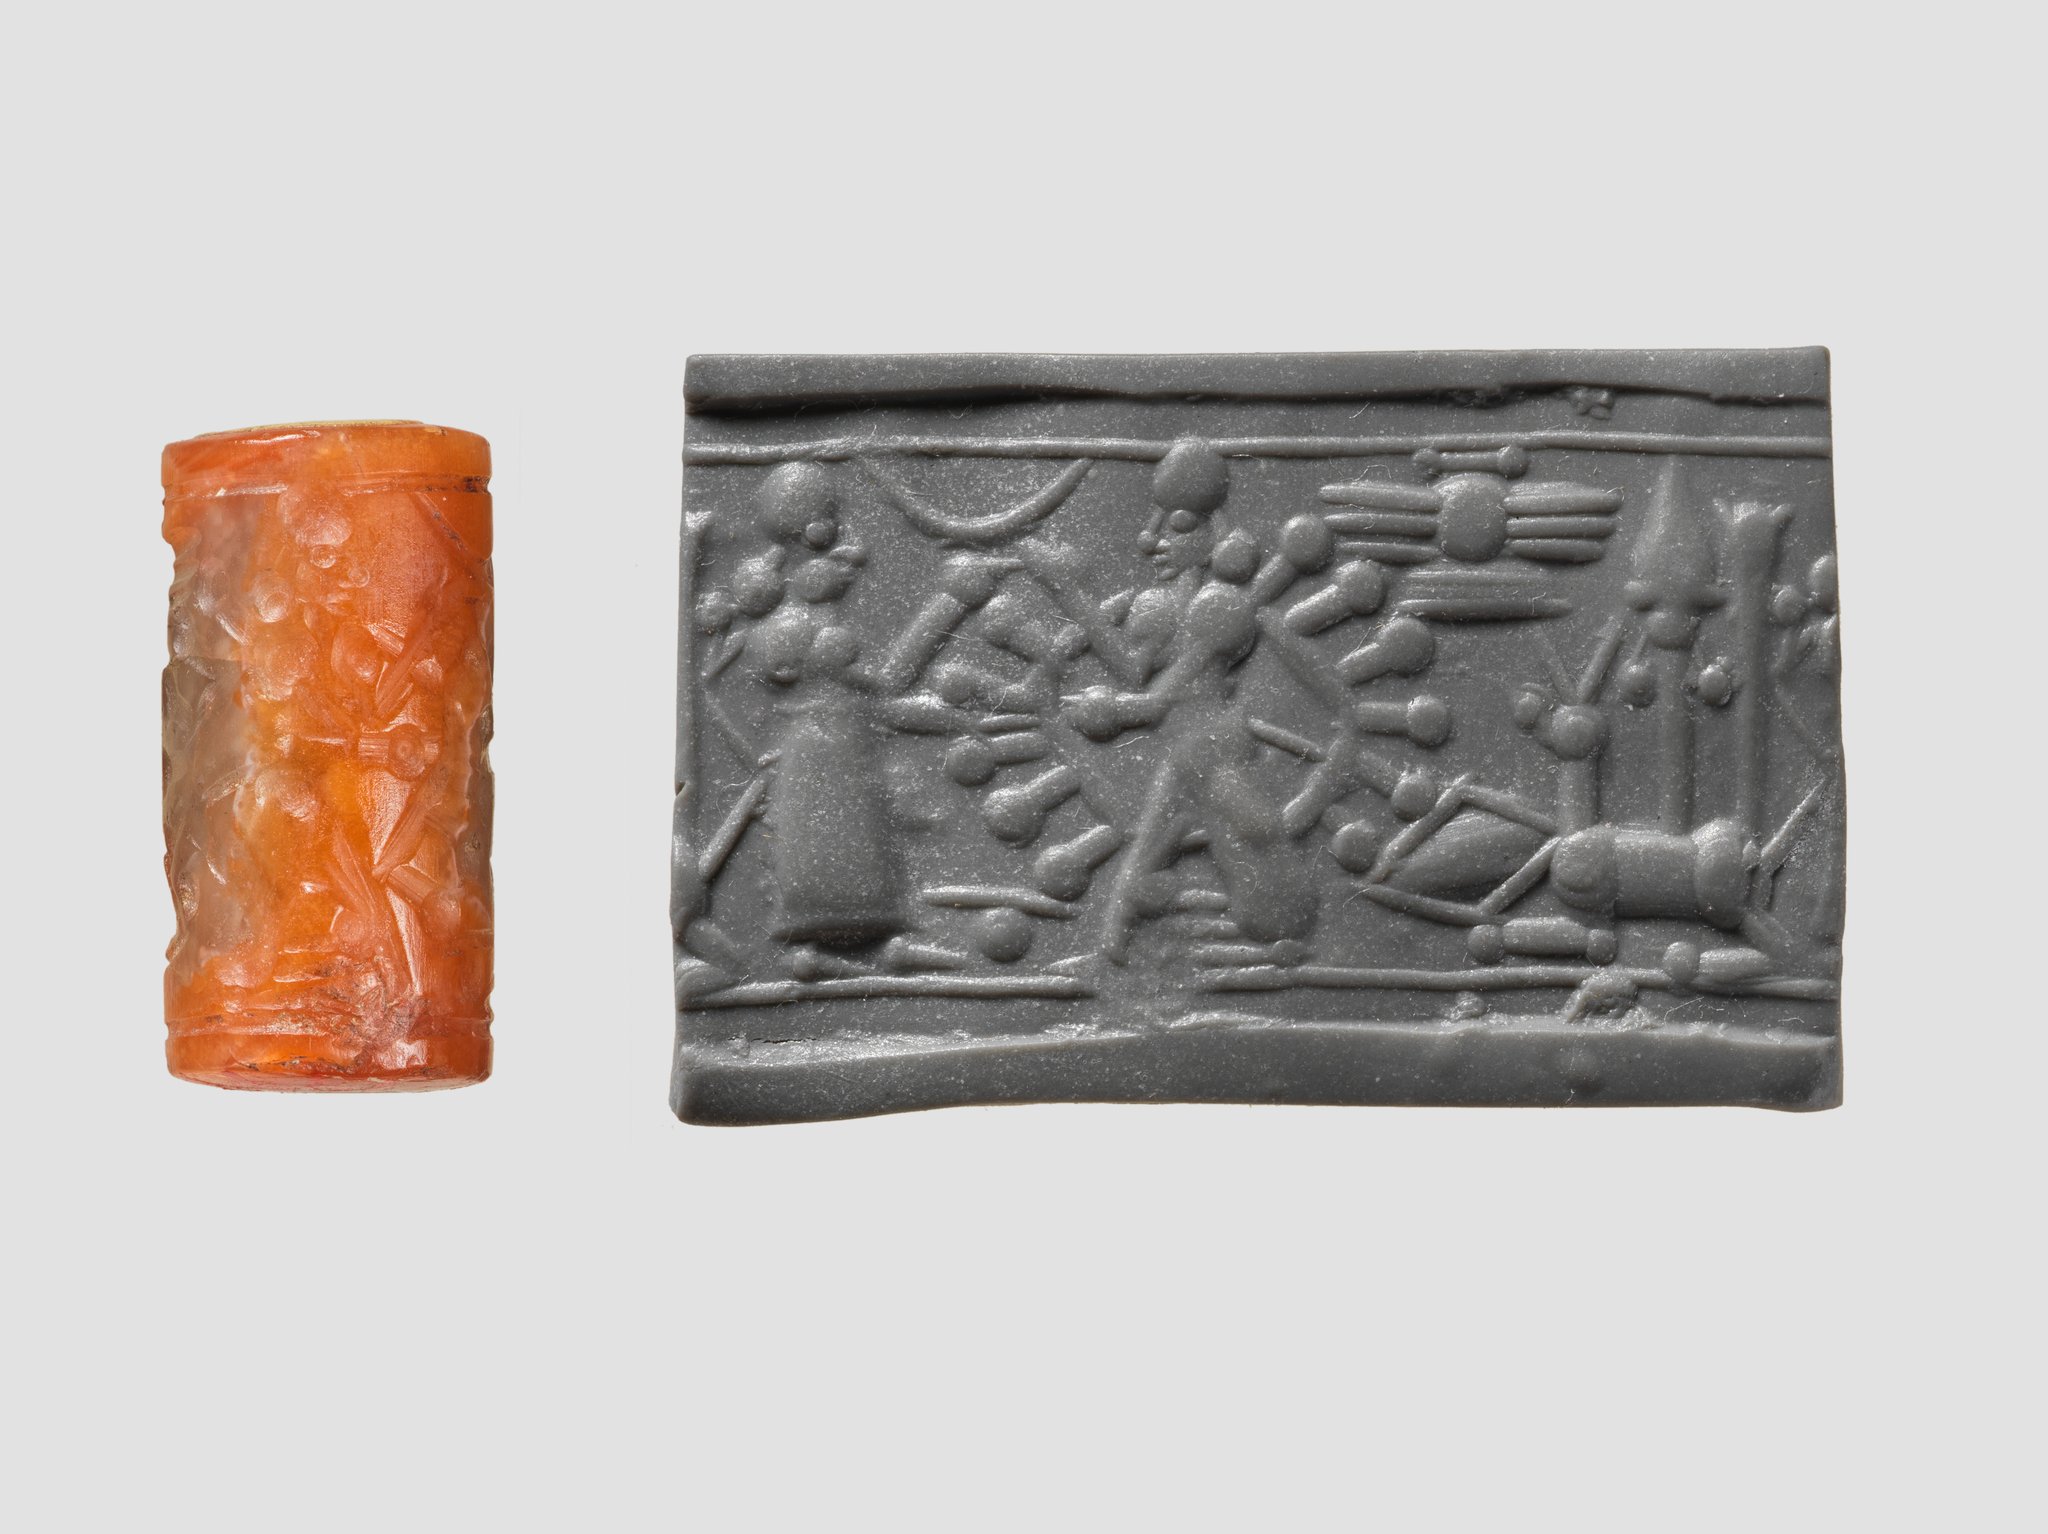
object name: cylinder seal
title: Cylinder seal with cultic scene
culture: assyrian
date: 734-601 BCE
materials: stone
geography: mesopotamia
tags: deer